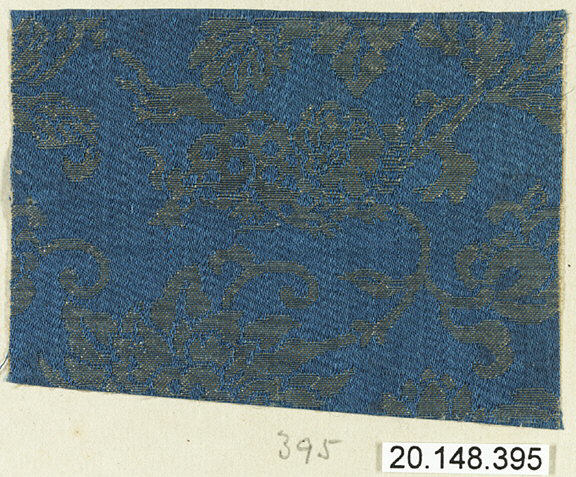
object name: piece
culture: japanese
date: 1601-1700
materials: silk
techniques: compound weave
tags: flowers,leaves